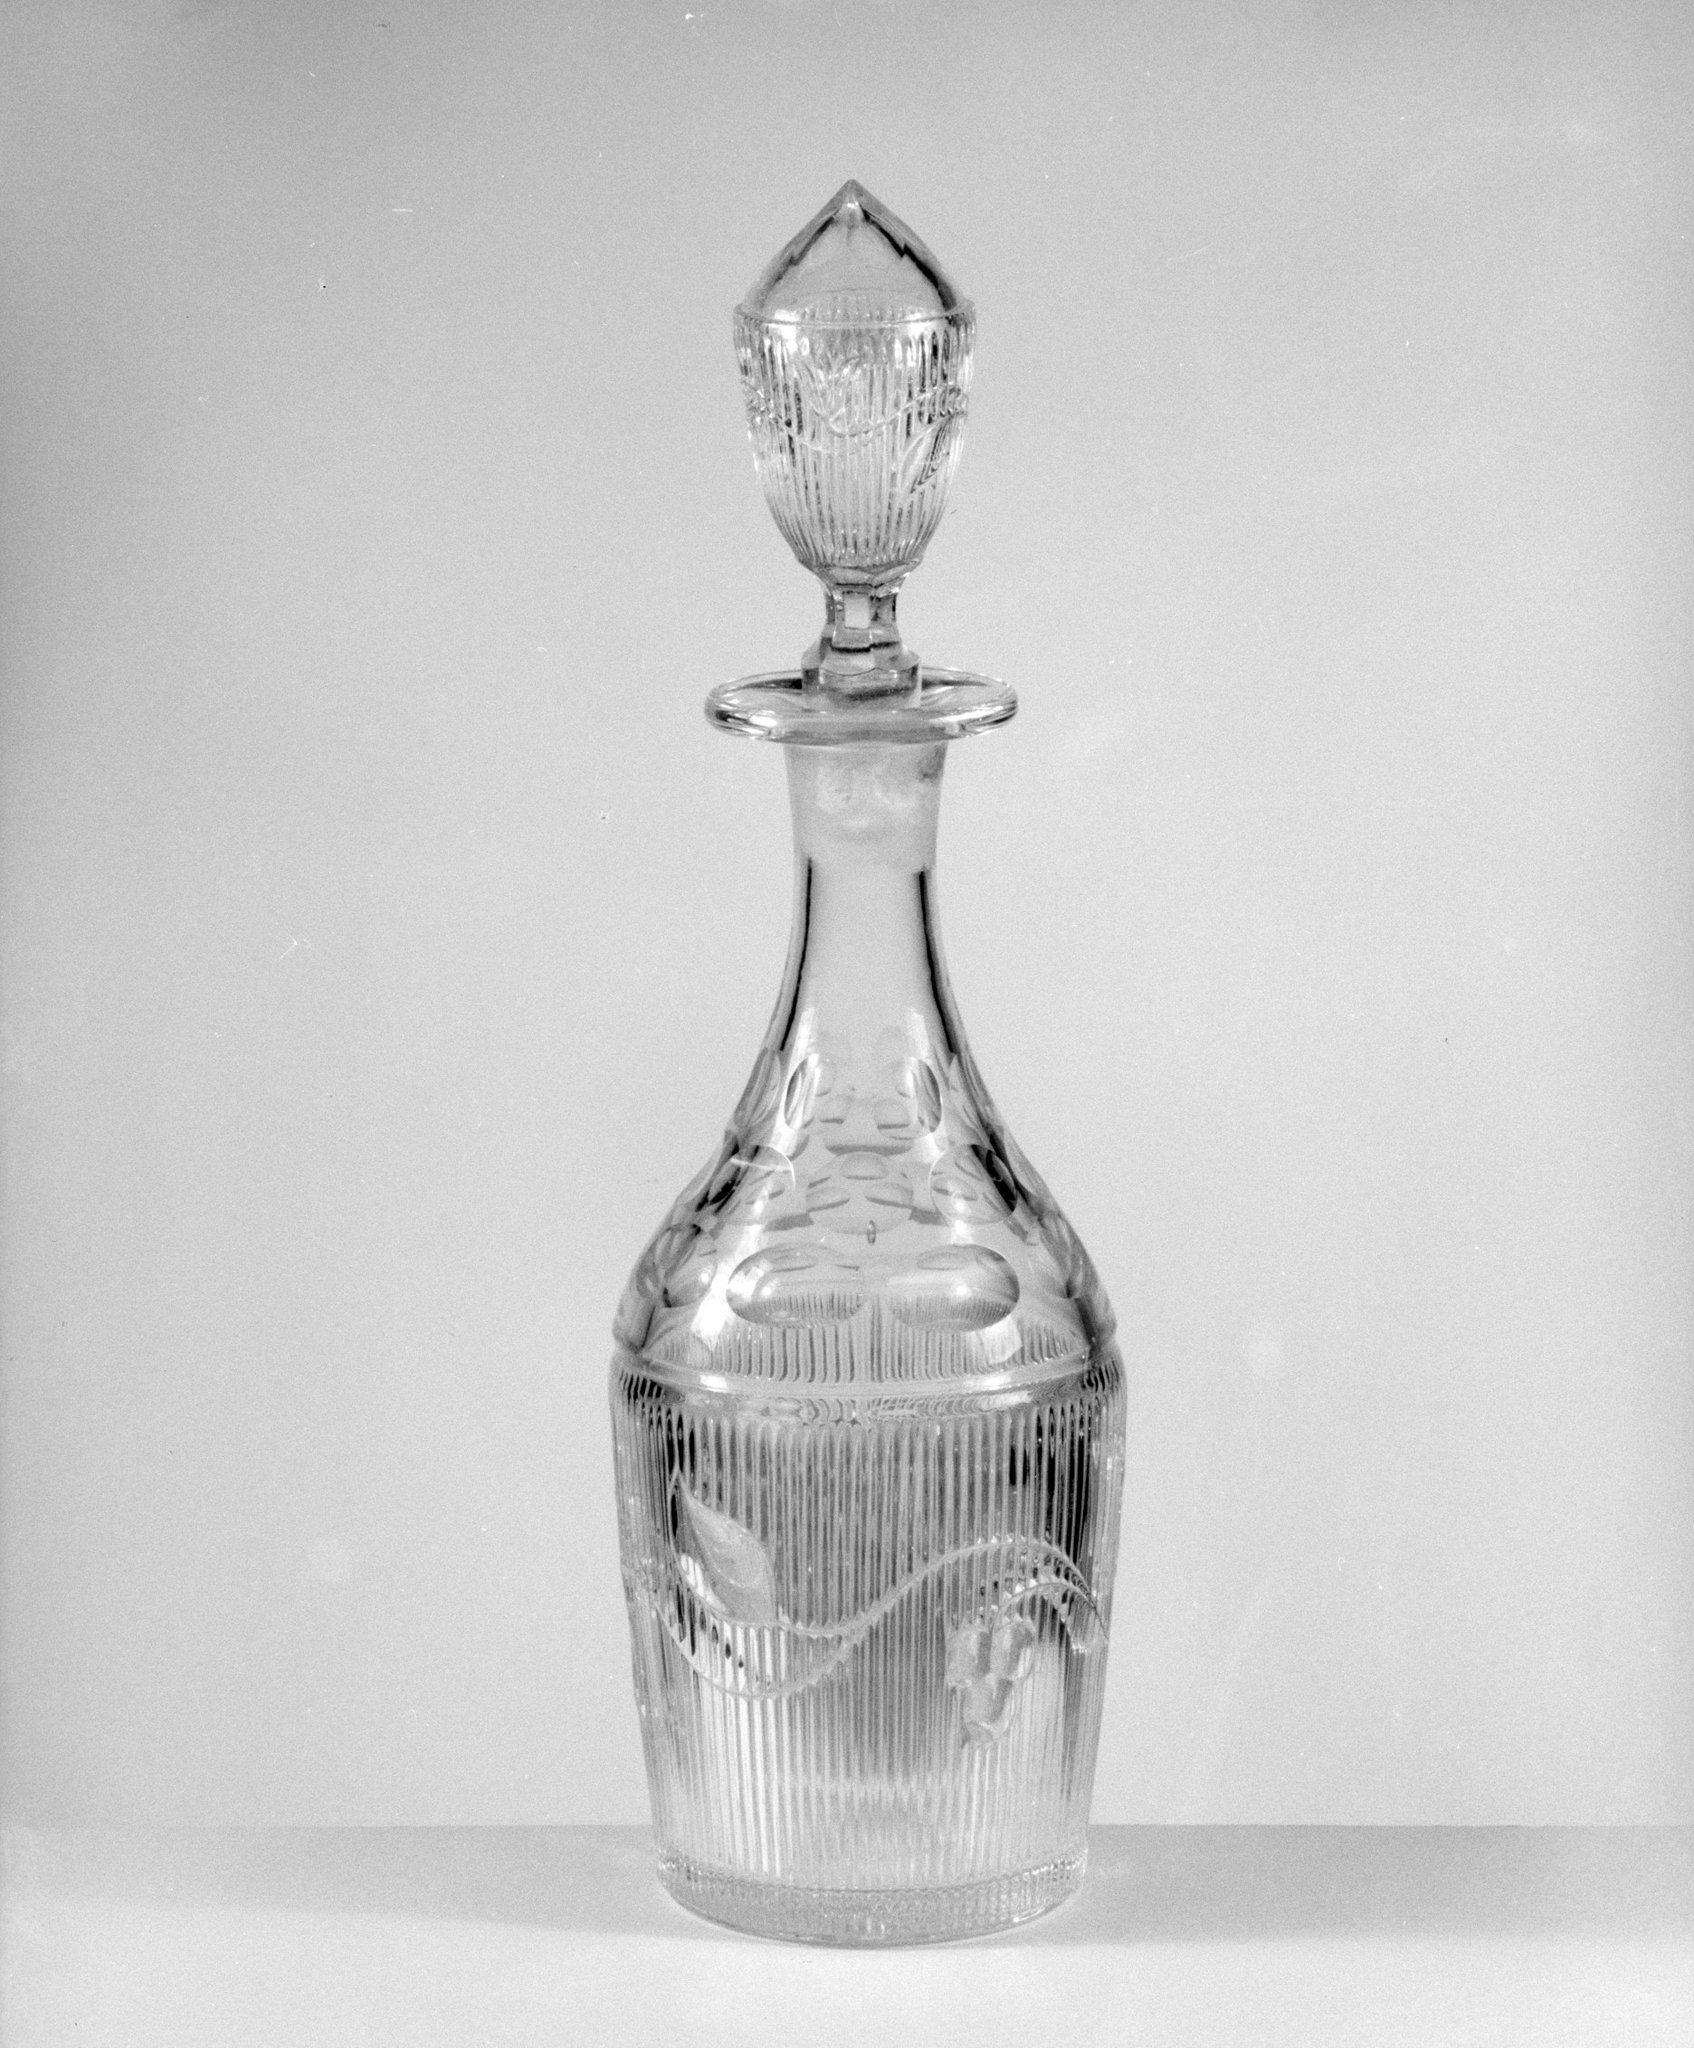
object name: decanter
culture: american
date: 1850-1870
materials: glass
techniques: pressed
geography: united states